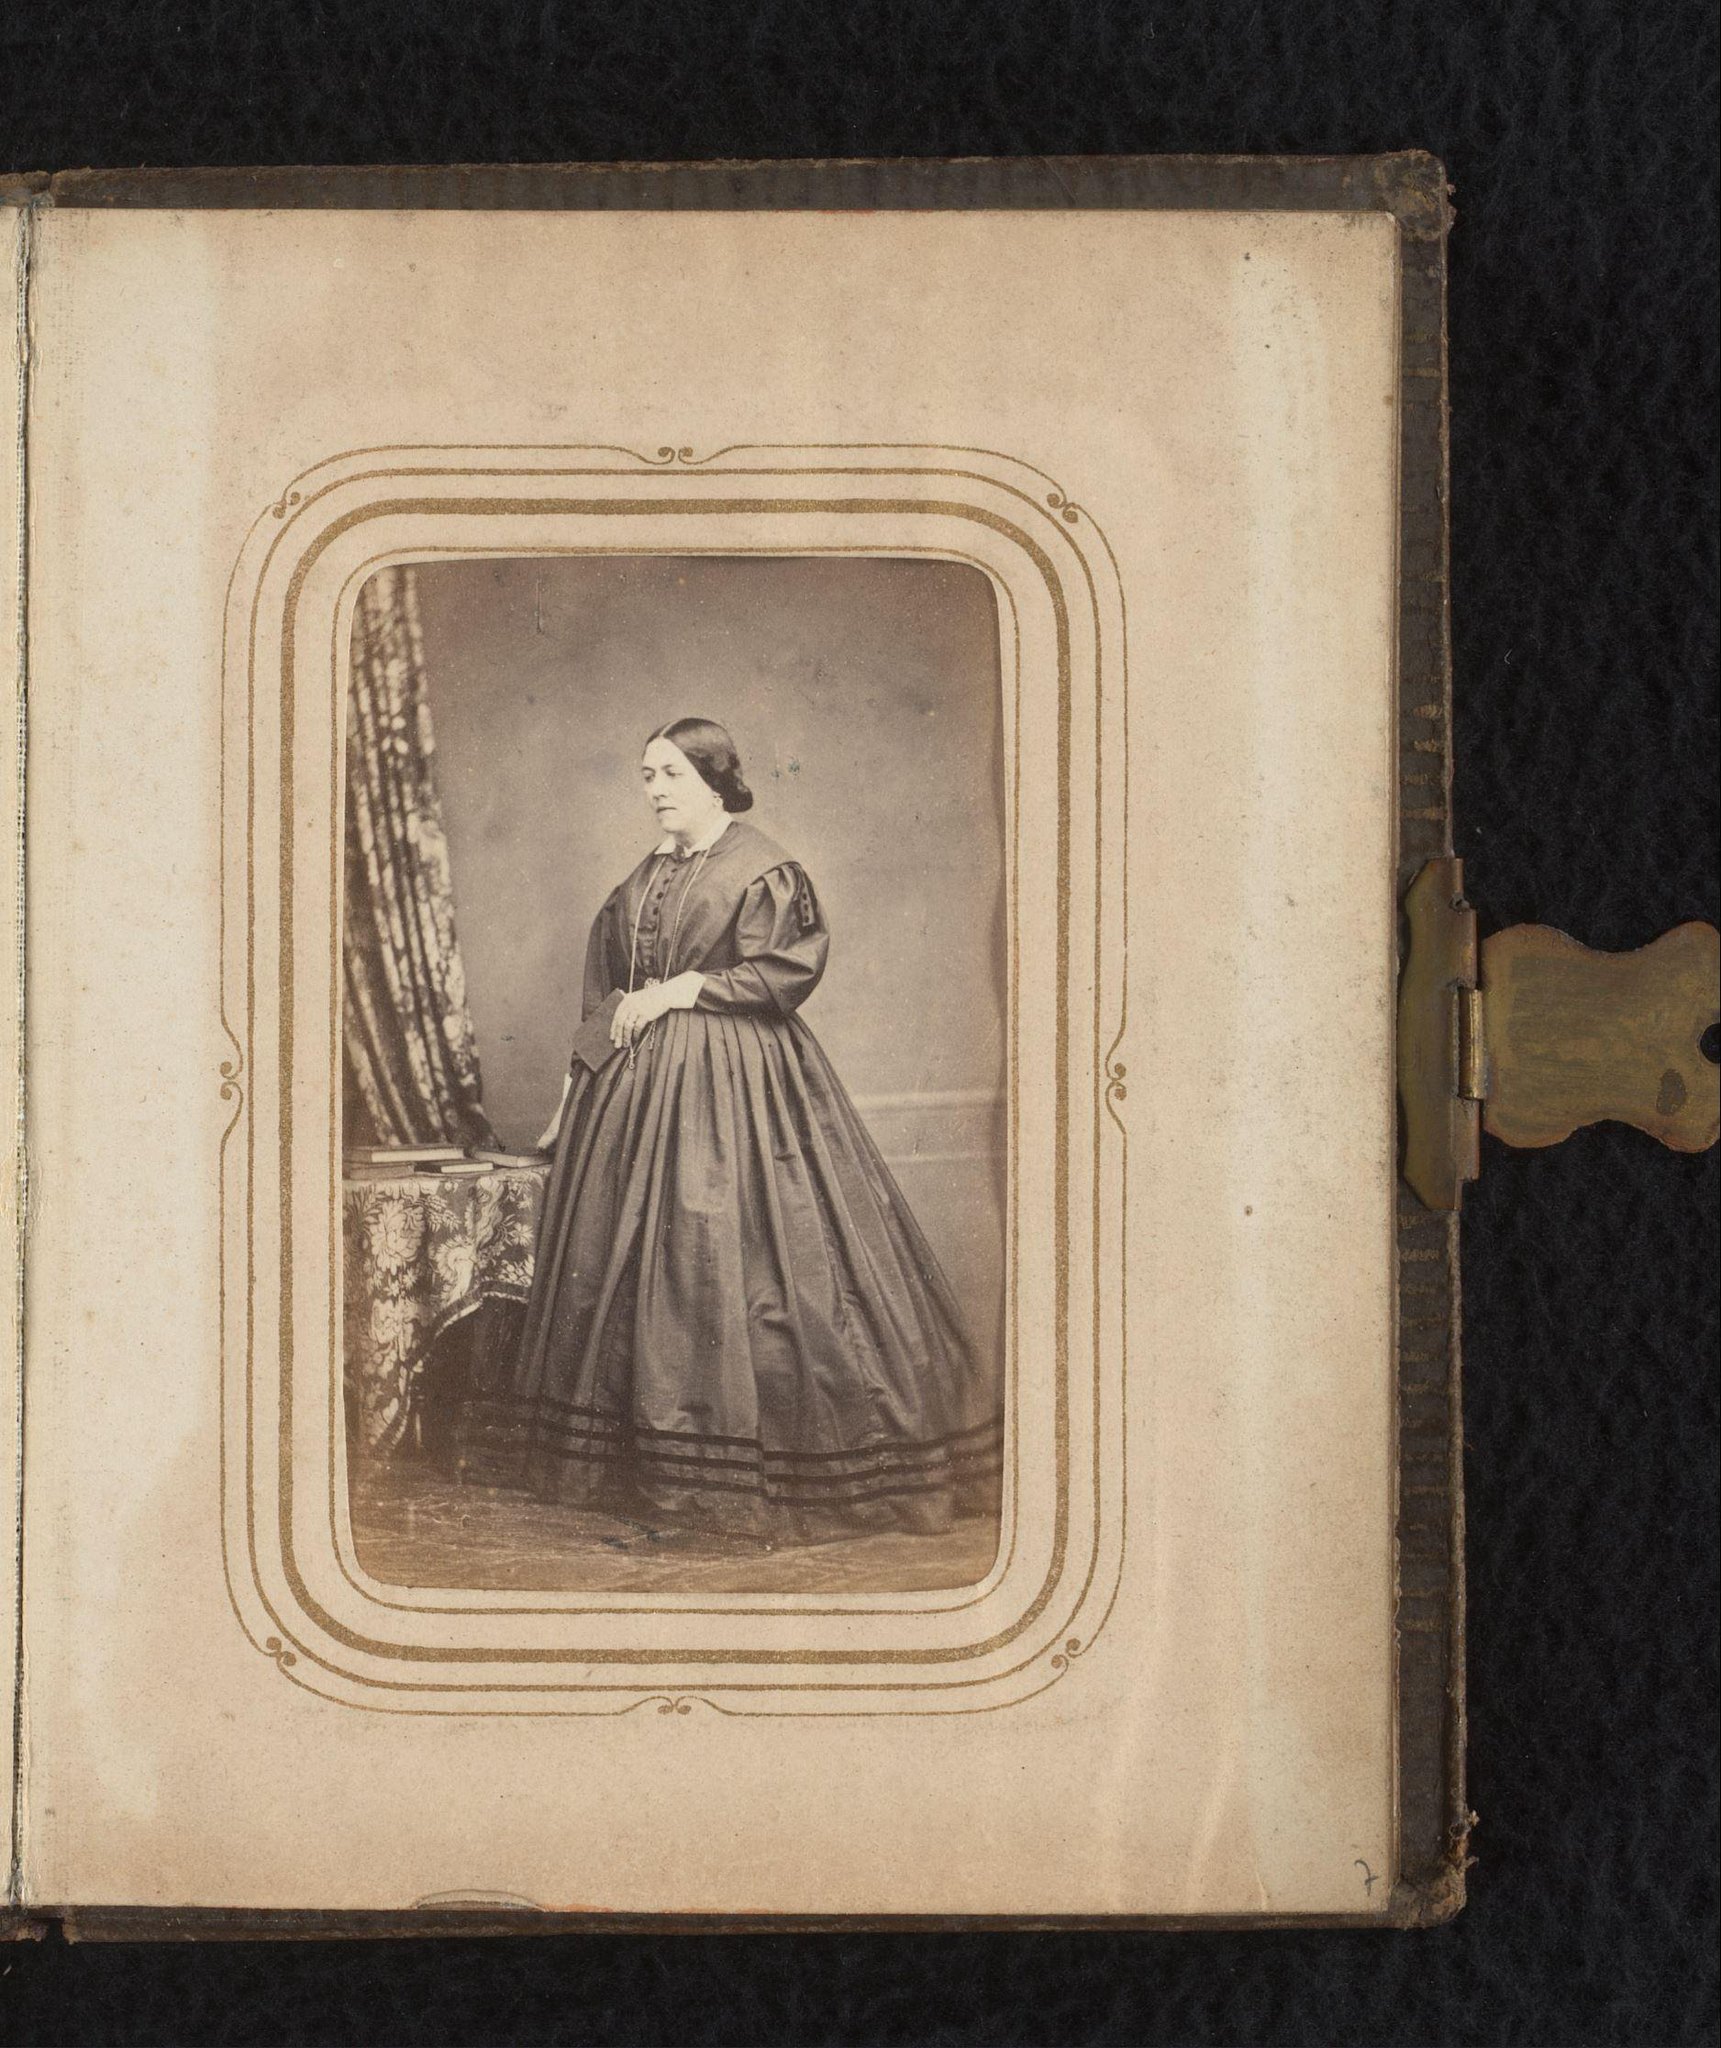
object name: photograph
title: Portret van een staande vrouw met boek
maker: r. griffiths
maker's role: fotograaf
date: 1860-1900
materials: cardboard, photographic support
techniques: albumen print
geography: truro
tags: historical persons - bb - woman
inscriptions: inscription: ‘Photographed by/ Mr. R. Griffiths/ Truro/ Artist/ Under Government’